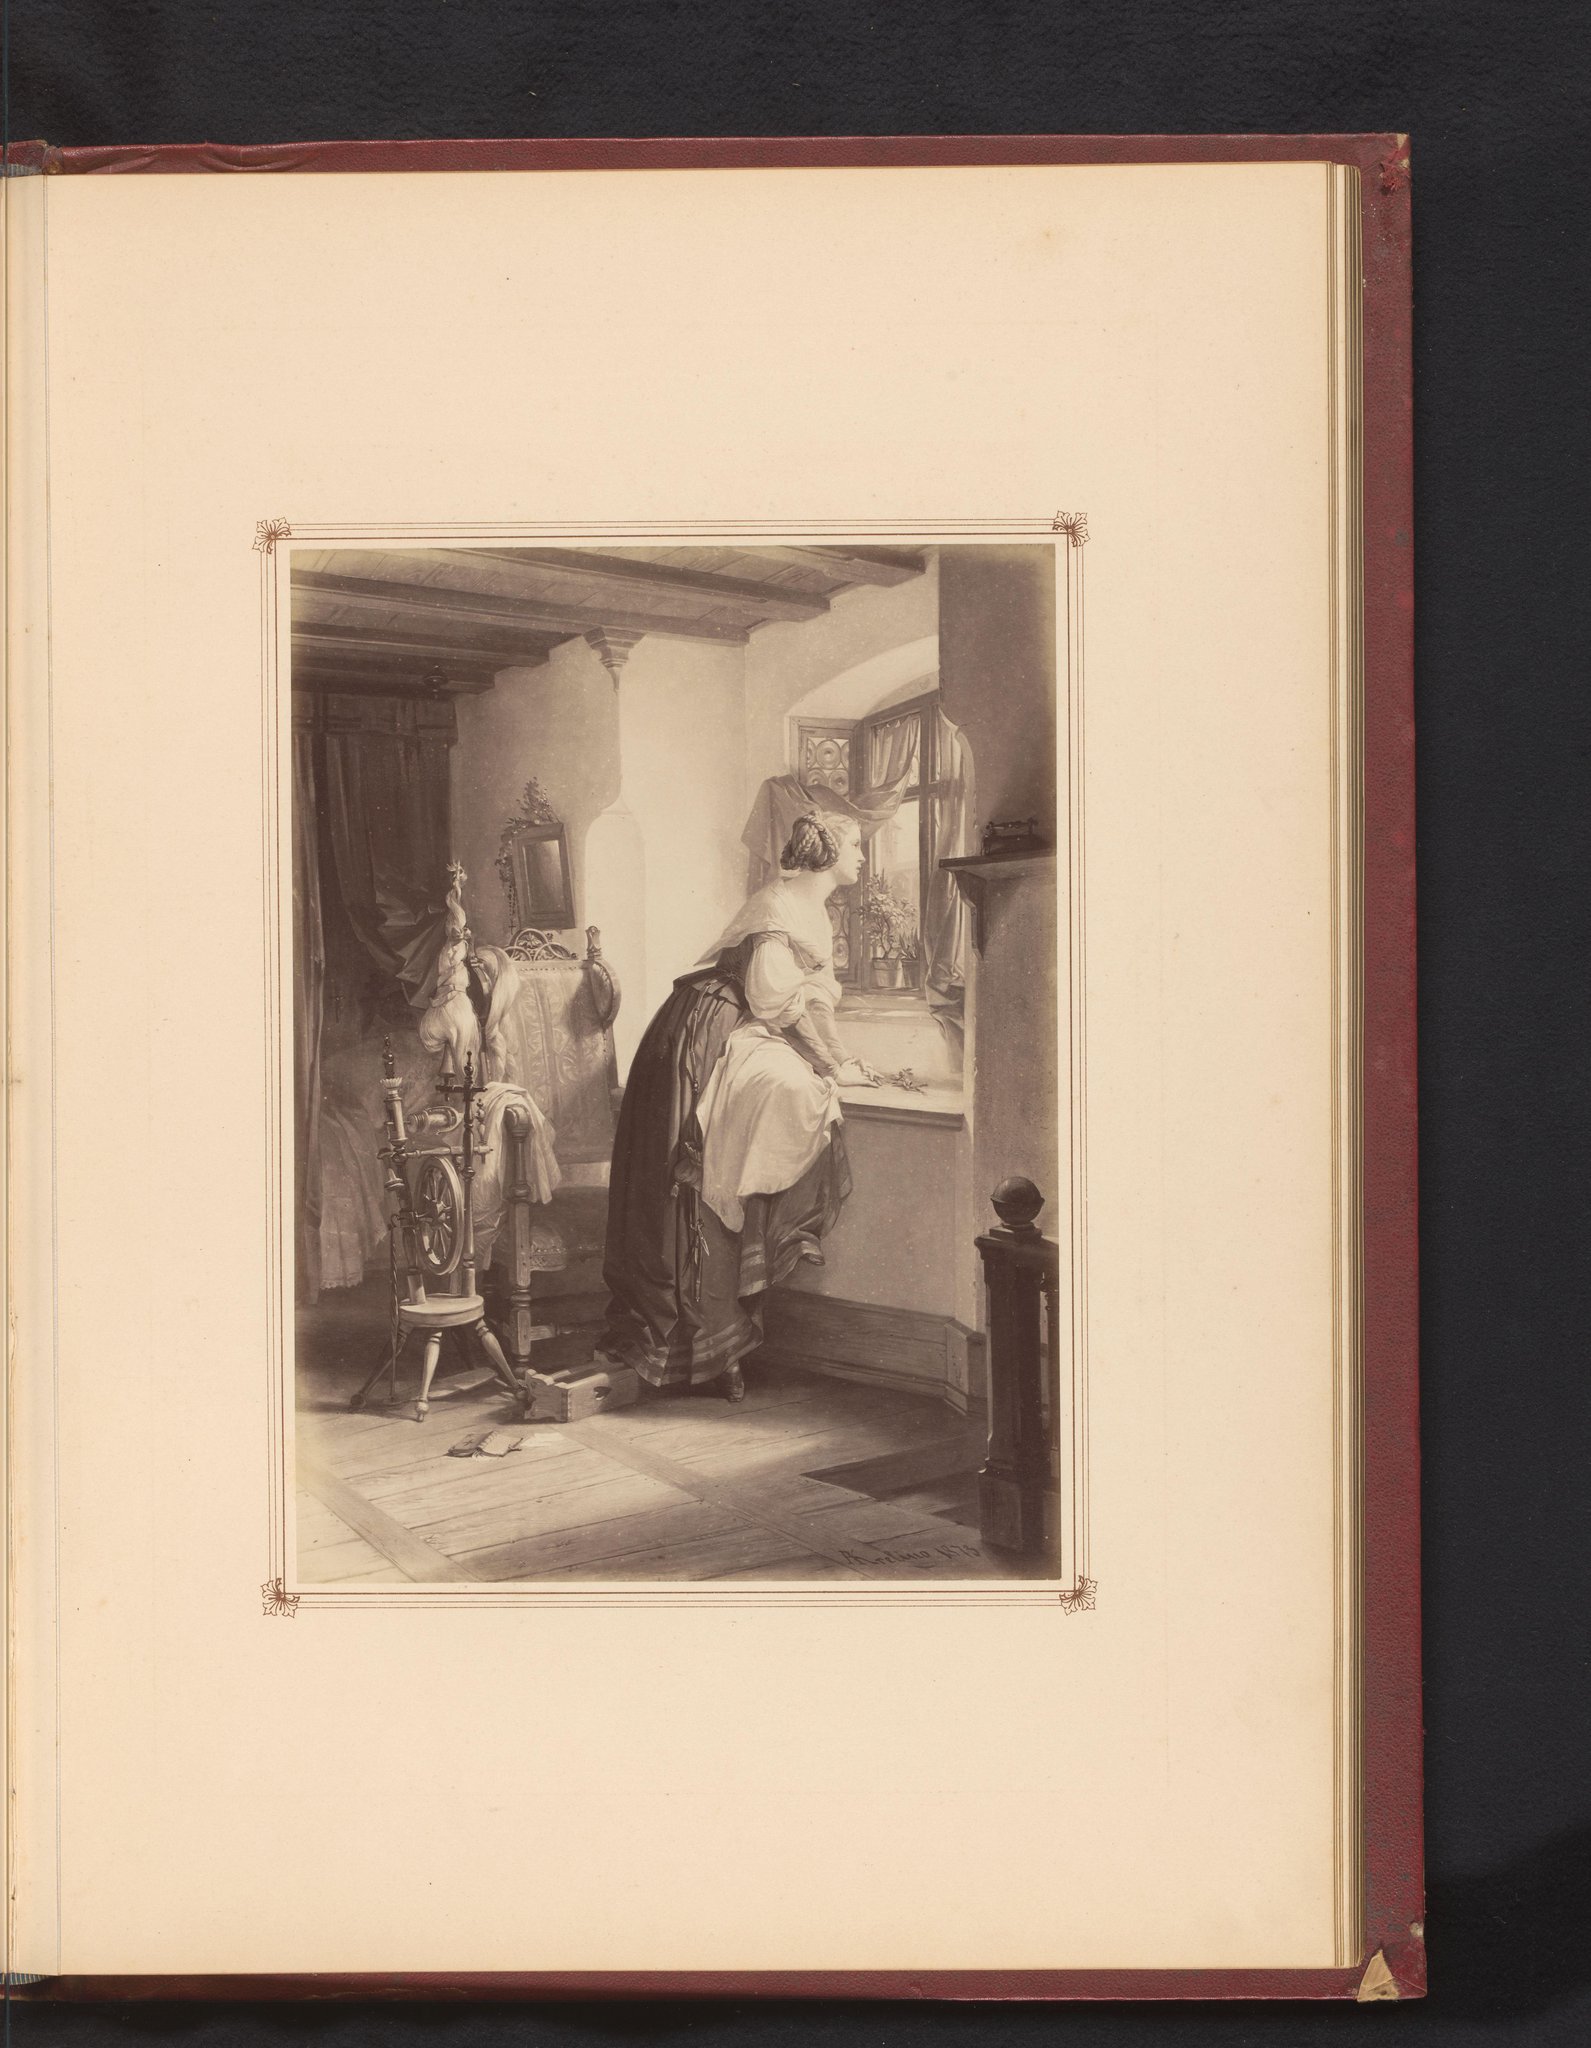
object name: reproduction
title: Fotoreproductie van een tekening van Gretchen, uit het eerste deel van de tragedie Faust door Johann Wolfgang von Goethe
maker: friedrich bruckmann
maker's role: publisher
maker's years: 1814-1898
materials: photographic support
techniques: albumen print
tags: (scenes from) specific works of literature: goethe, faust